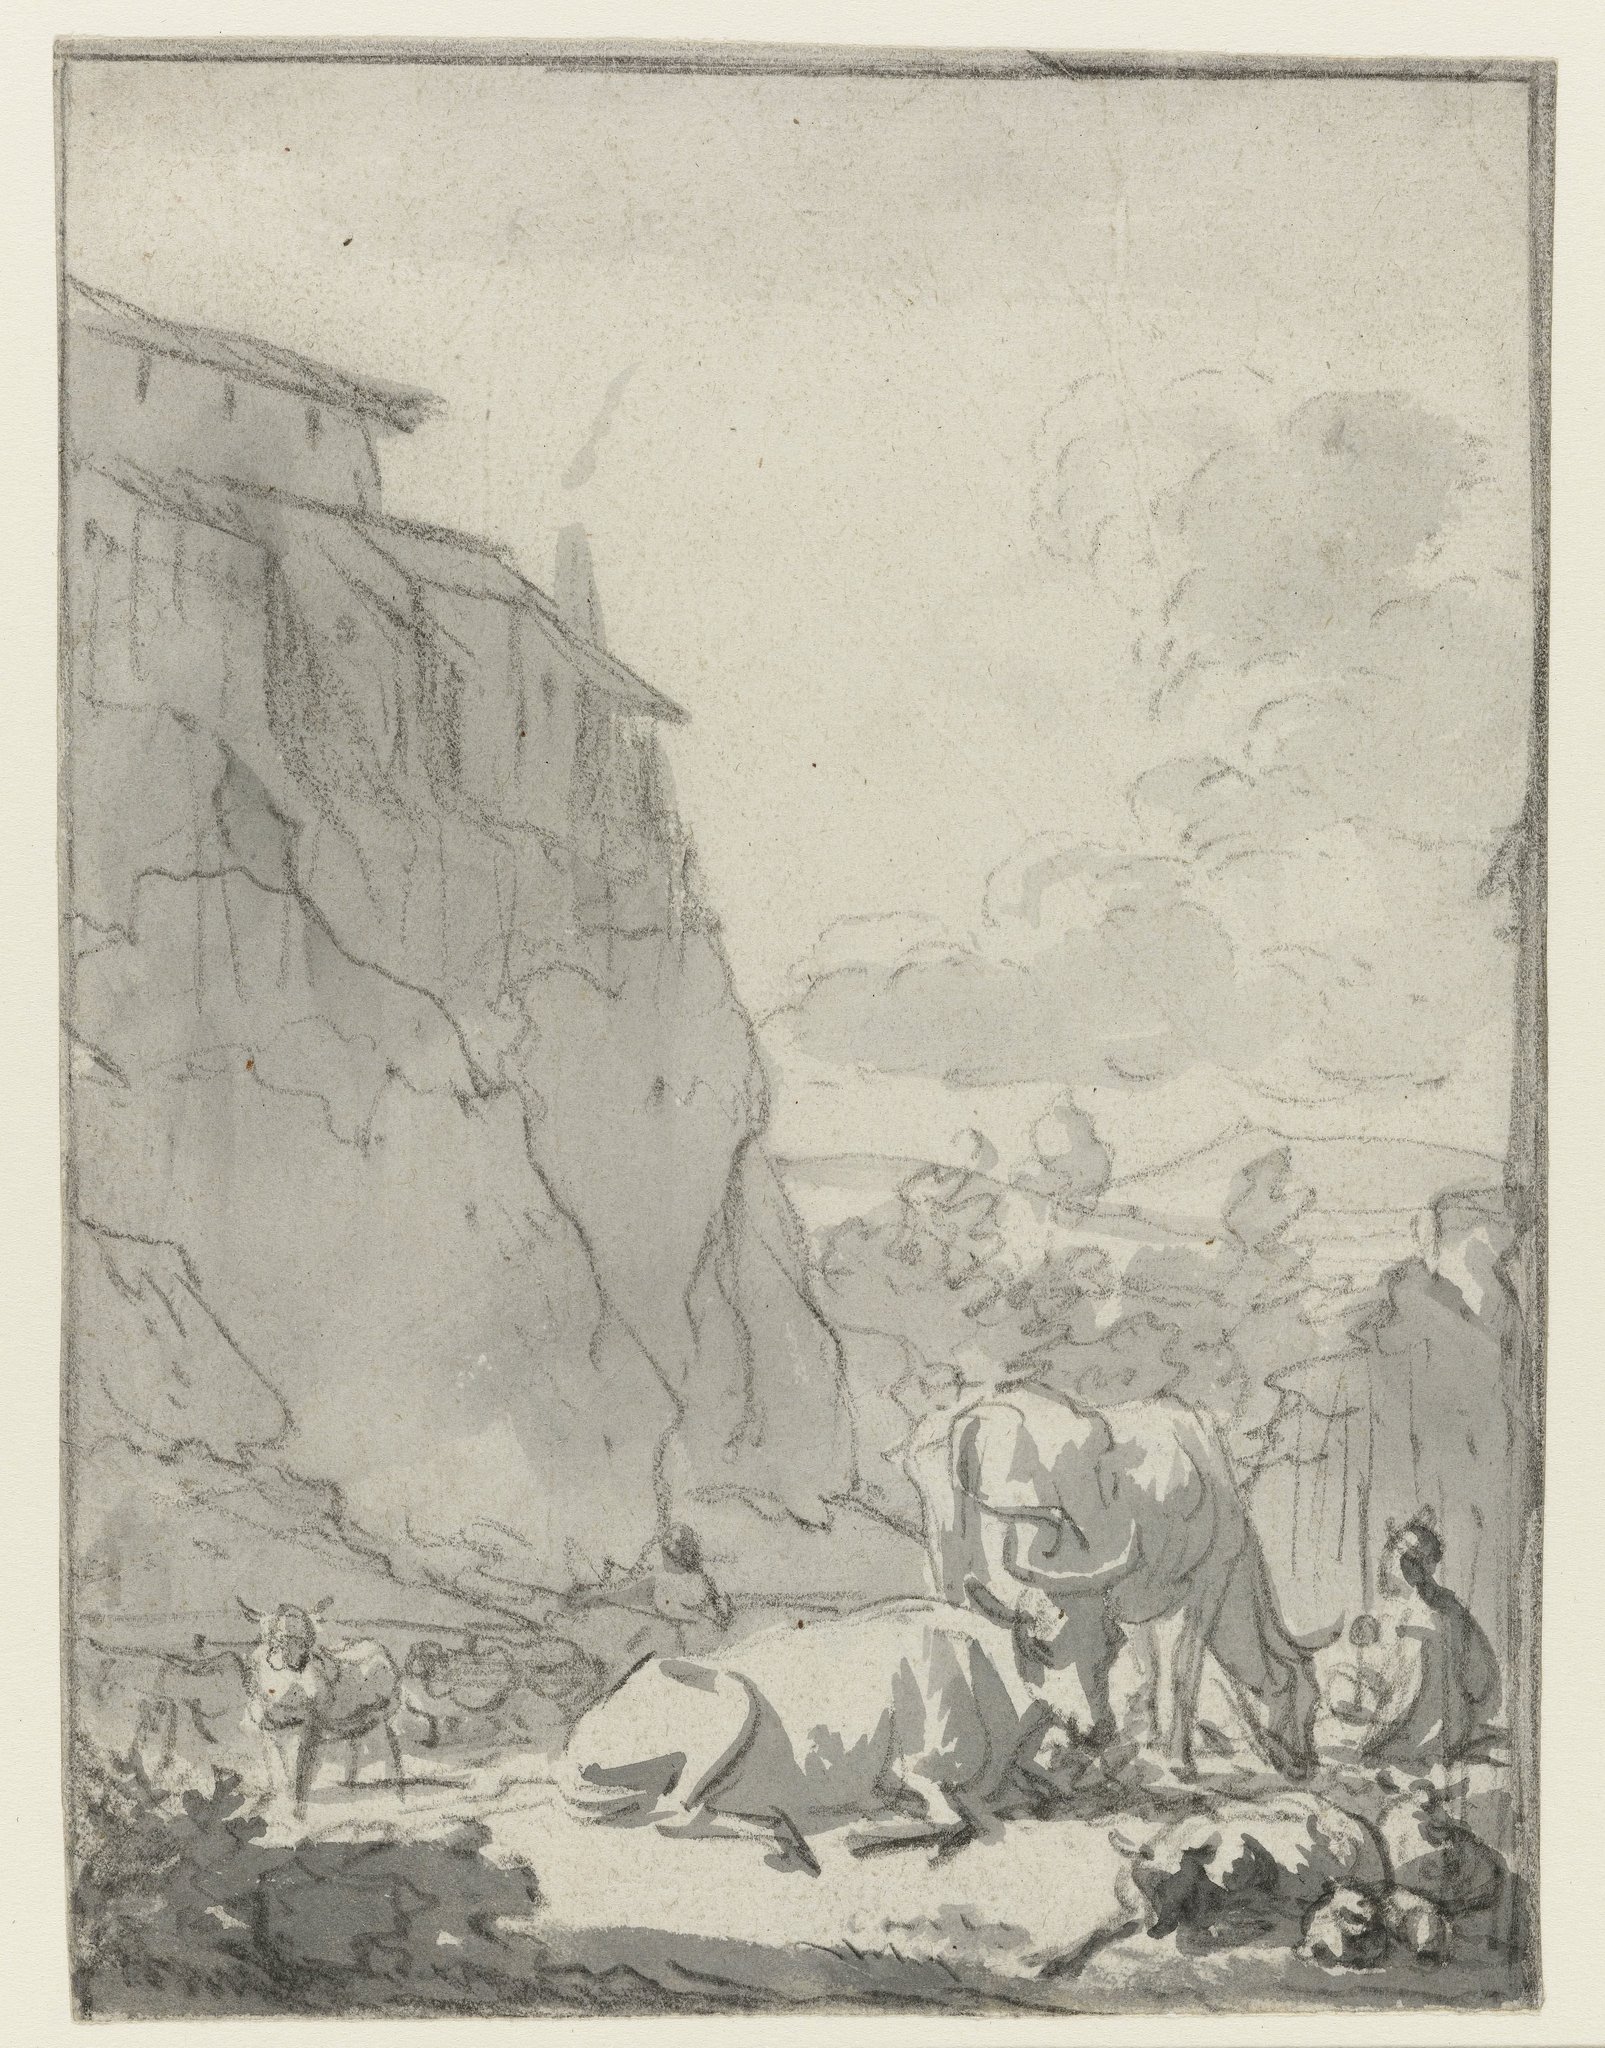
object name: drawing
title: Herder met koeien en schapen in een Italianiserend landschap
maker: adriaen van de velde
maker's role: draughtsman, painter, print maker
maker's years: 1636-1672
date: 1646-1672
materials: chalk, paper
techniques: brush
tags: herd, flock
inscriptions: annotation: ‘Declar. nr. 14 1886’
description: Op een rots linksachter een bouwsel dat abusievelijk is geduid als de kerk S. Trinità dei Monti.